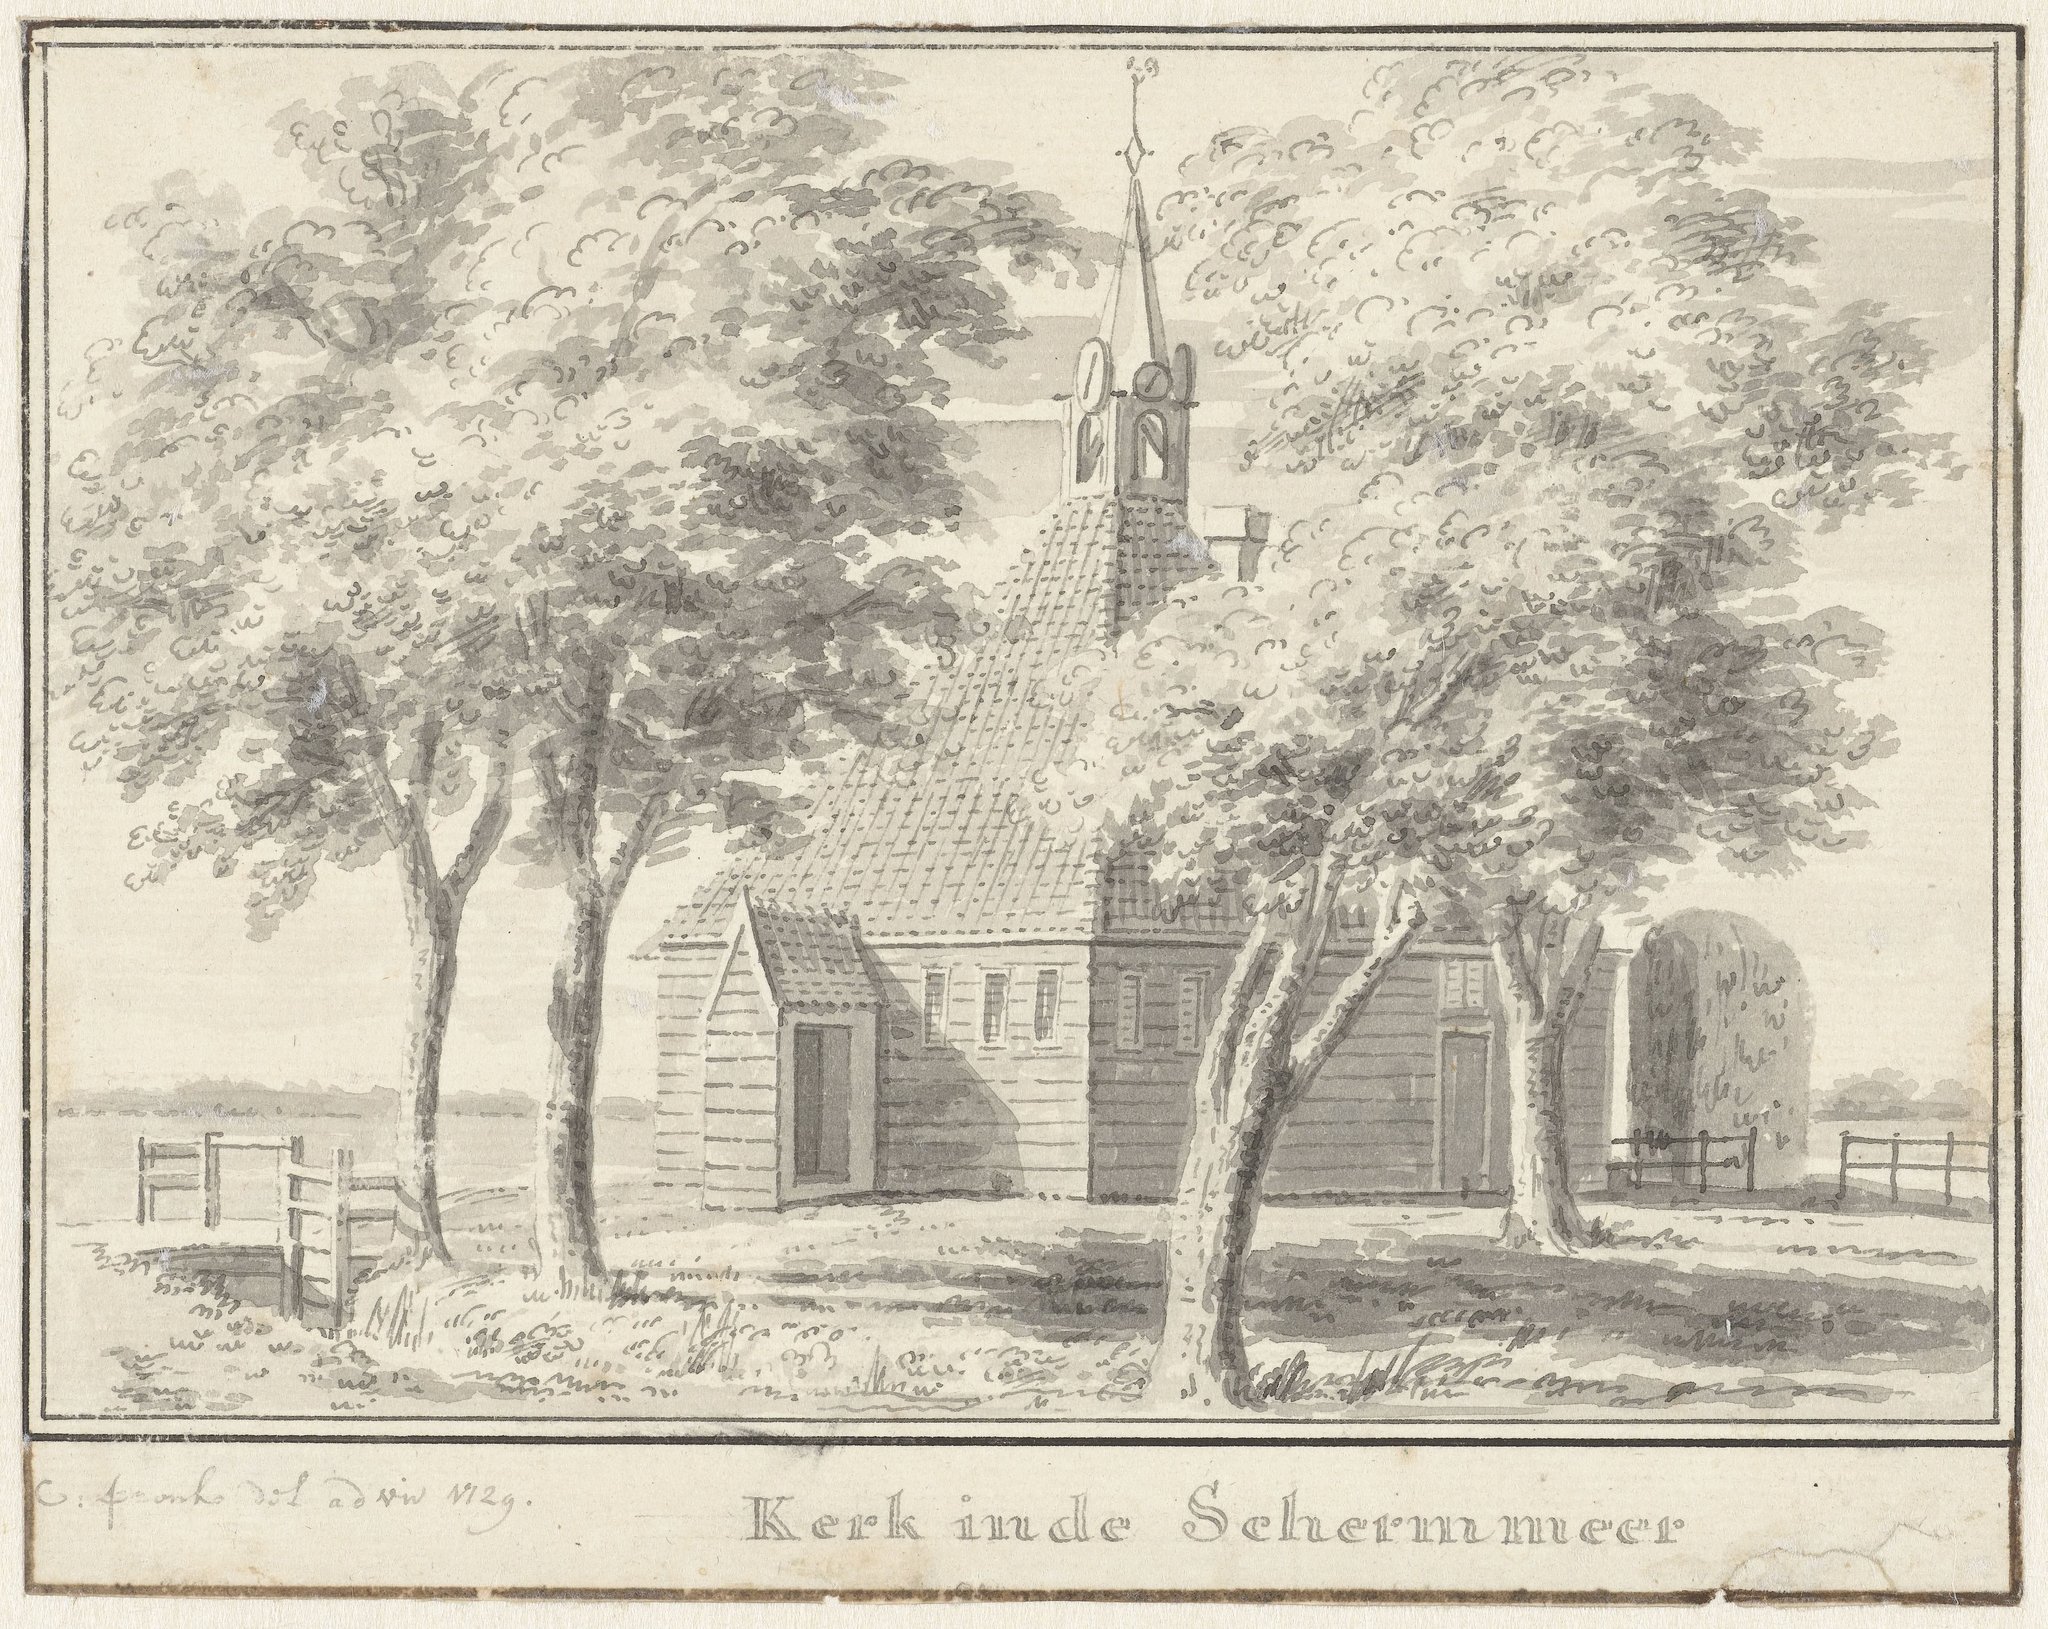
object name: drawing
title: De kerk in de Schermmeer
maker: cornelis pronk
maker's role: draughtsman, painter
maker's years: 1691-1759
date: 1729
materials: ink, paper, pencil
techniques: brush, pen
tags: church (exterior)